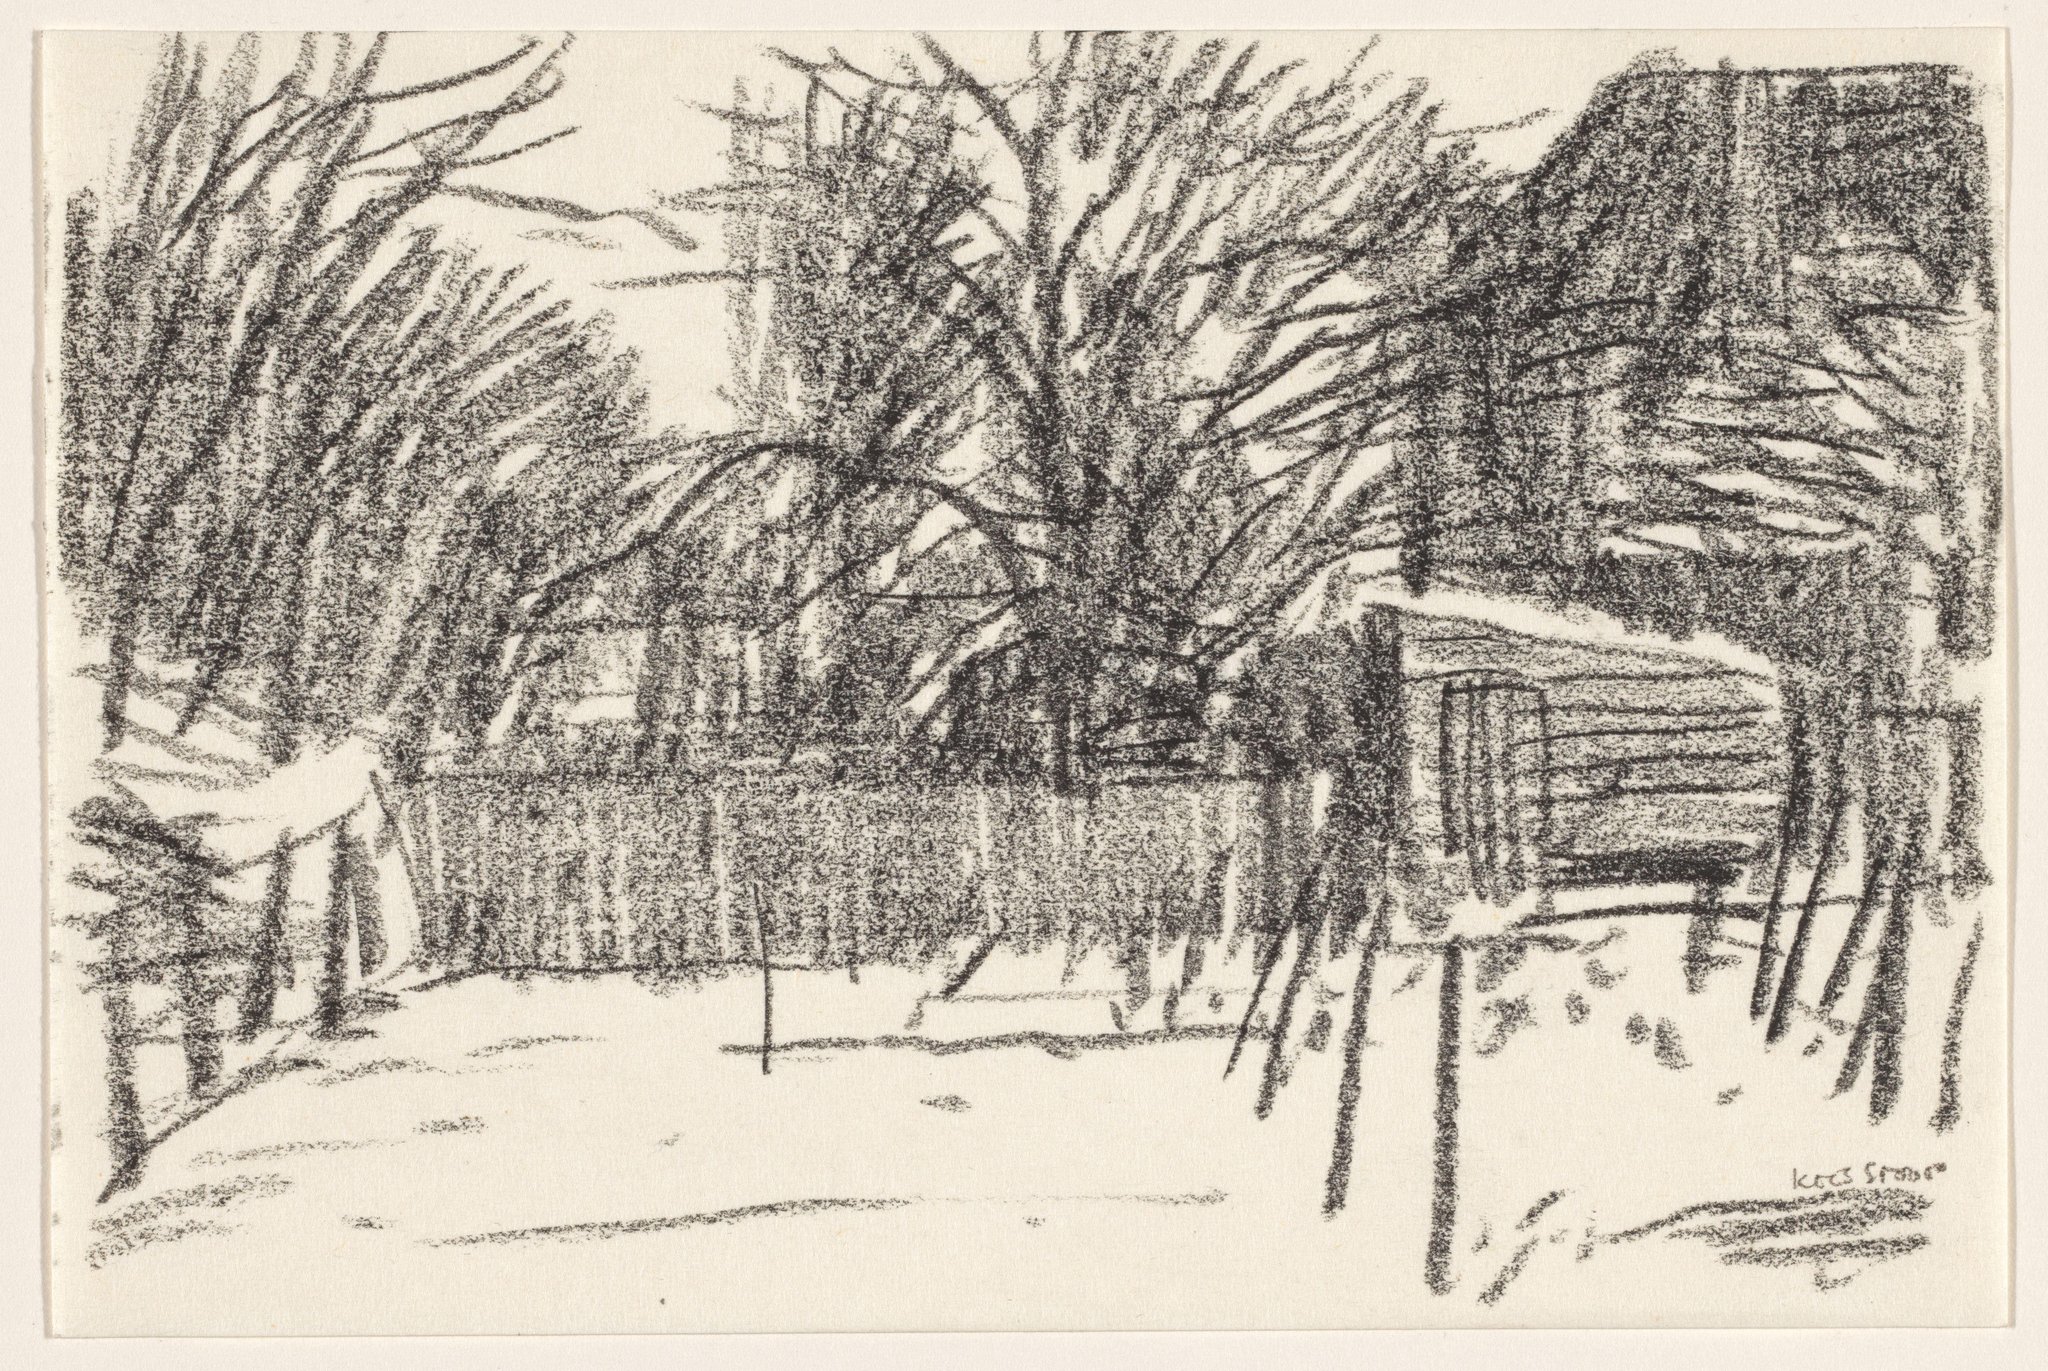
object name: drawing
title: Land met hek, bomen en schuur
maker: kees stoop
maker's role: draughtsman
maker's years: 1929-2019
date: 1939-2009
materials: charcoal, paper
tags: fence, wall, paling, backyard